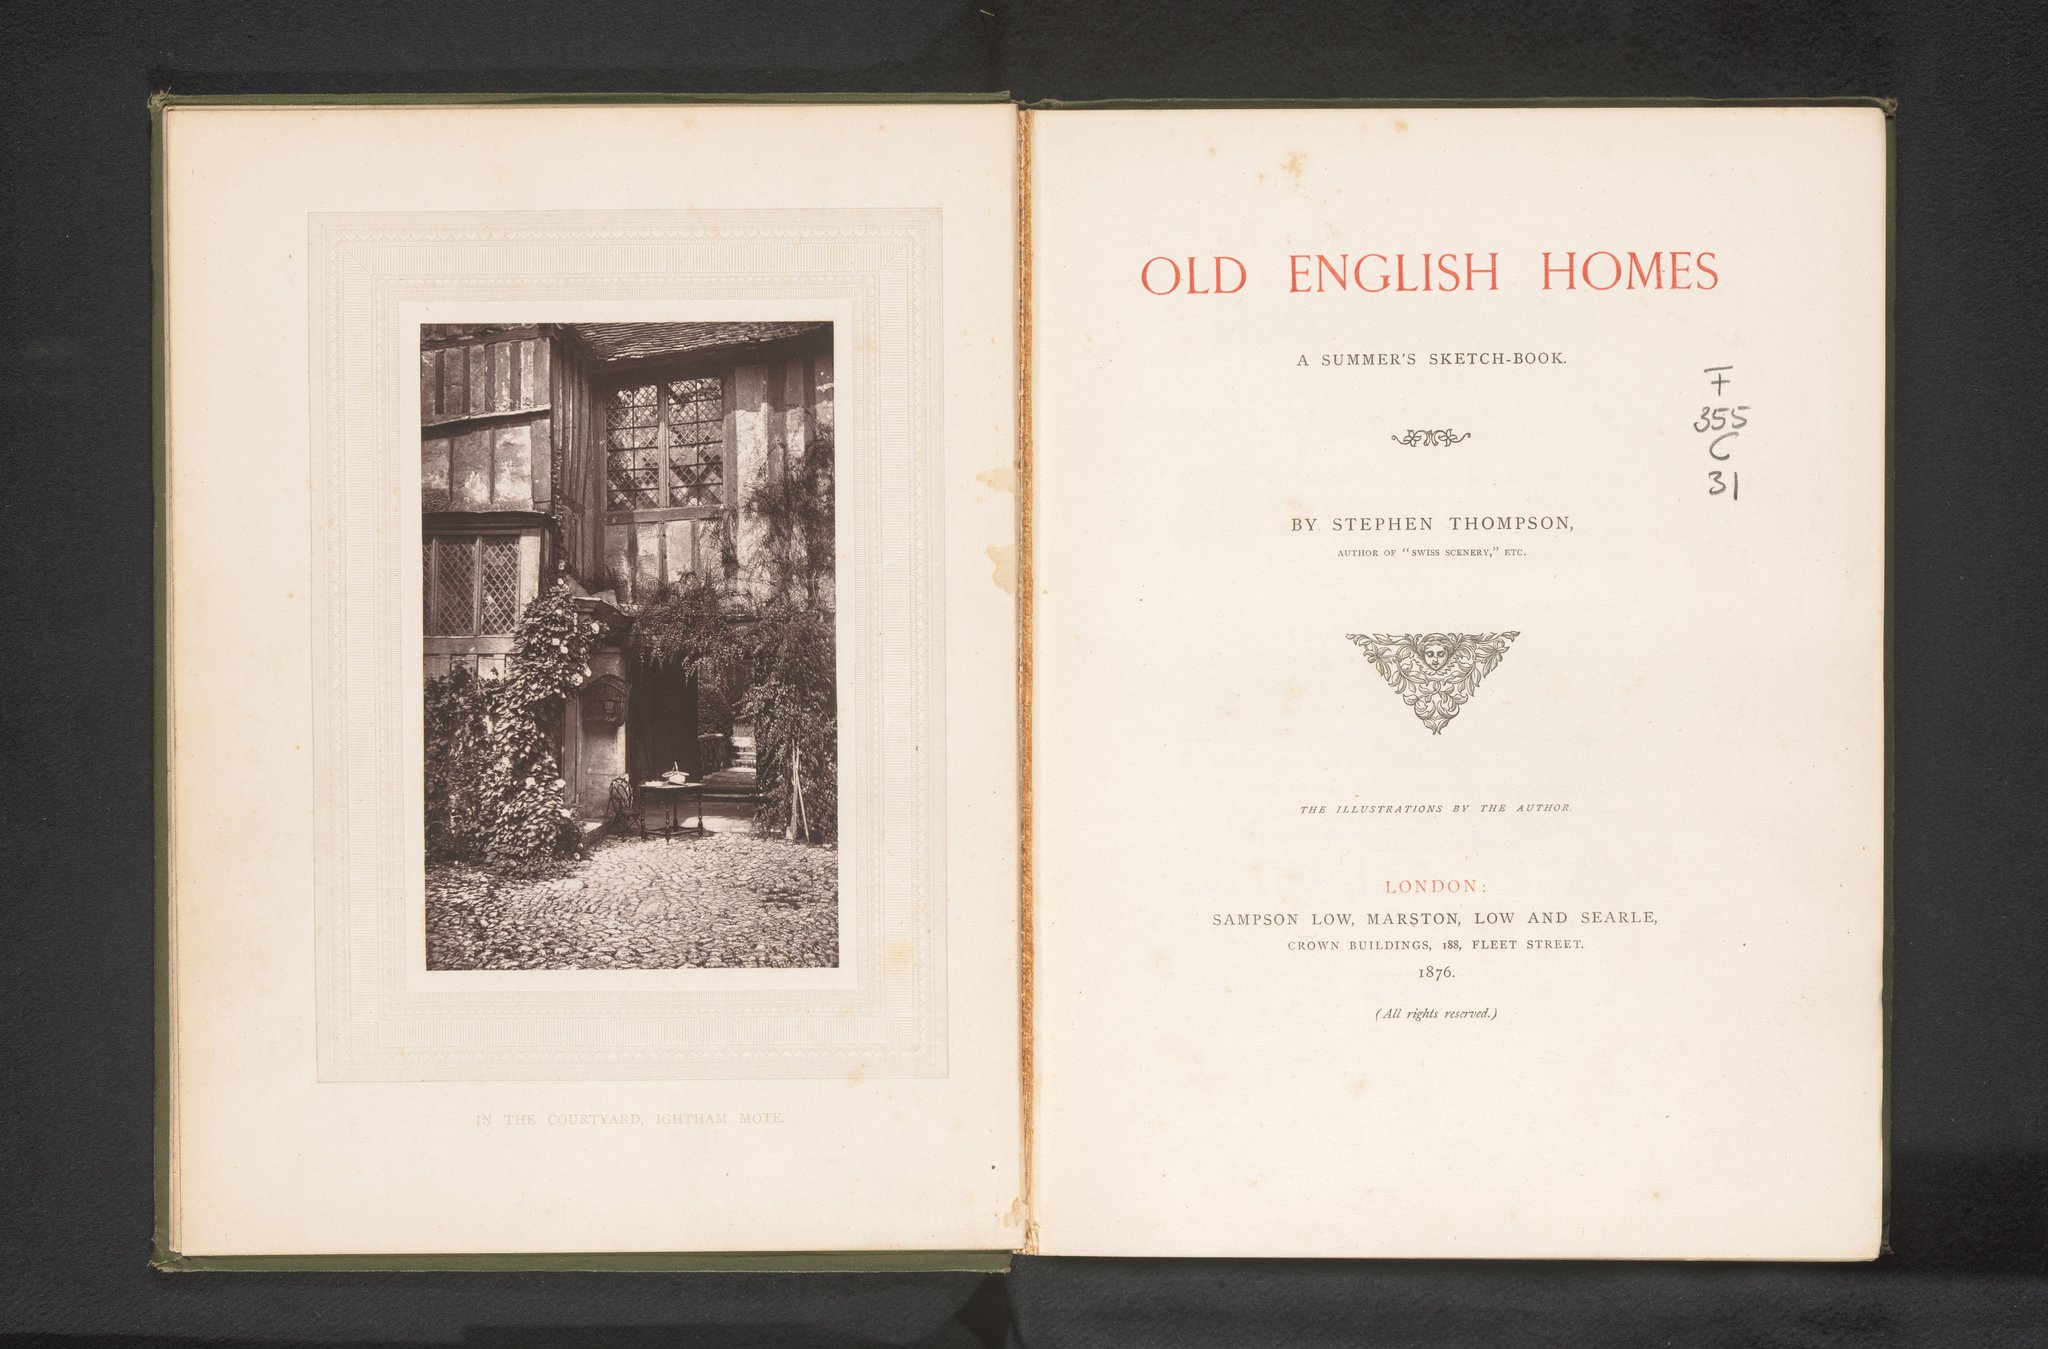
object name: book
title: Old English homes a summer's sketch-books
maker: stephen thompson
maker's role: fotograaf, schrijver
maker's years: 1831-1893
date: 1876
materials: linen, paper, photographic support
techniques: albumen print, woodburytype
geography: london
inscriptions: name: ‘ex libris SFJ’